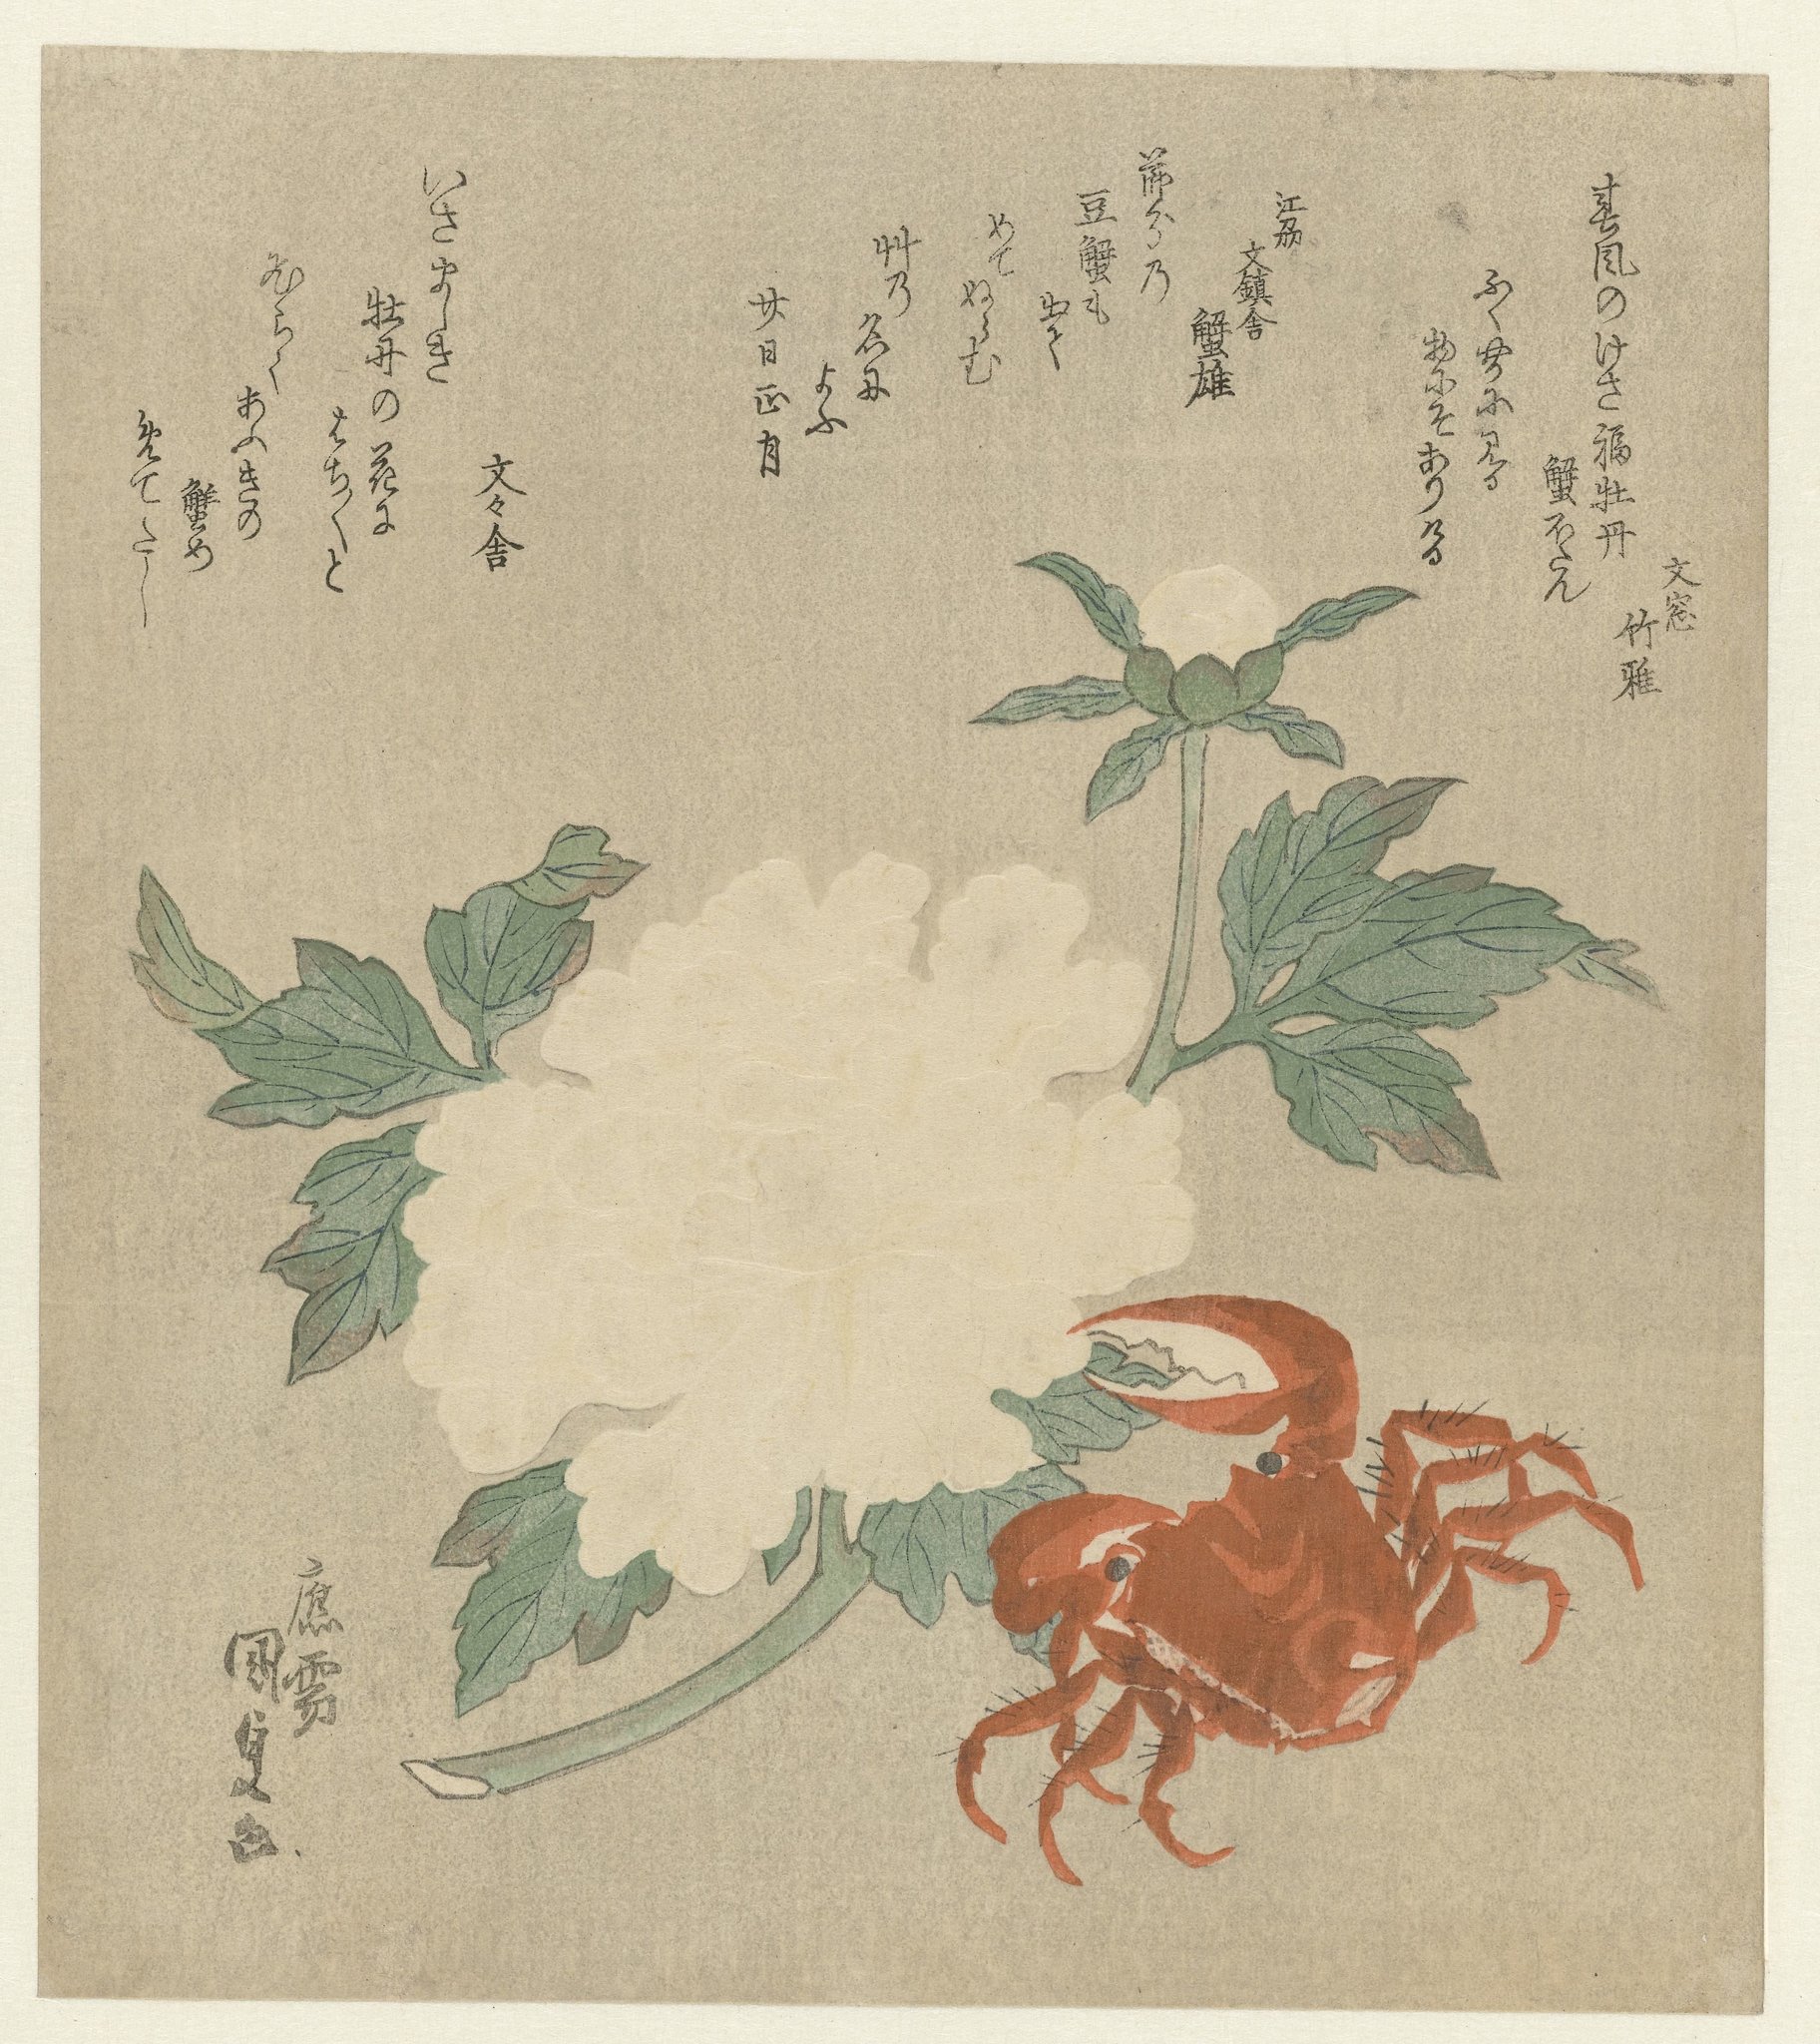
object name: surimono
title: Pioenroos met krab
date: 1831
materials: paper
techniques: blind stamped, woodcut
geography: japan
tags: plants and herbs: peony, crustaceans: crab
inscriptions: collector's mark, verso, stamped: Lugt 2228, collector's mark, passe-partout, bottom left, printed: JABdH with a rooster.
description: Een surimono is een luxe uitgevoerde prent waarop beeld met één of meerdere gedichten gecombineerd is. Bij het drukken van een surimono werd vaak gebruik gemaakt van dikker papier, blinddruk en metaal pigmenten, zoals koper- en zilverpoeder. De prenten werden vaak in opdracht van dichters gemaakt en als exclusief geschenk aan vrienden en relaties gegeven.